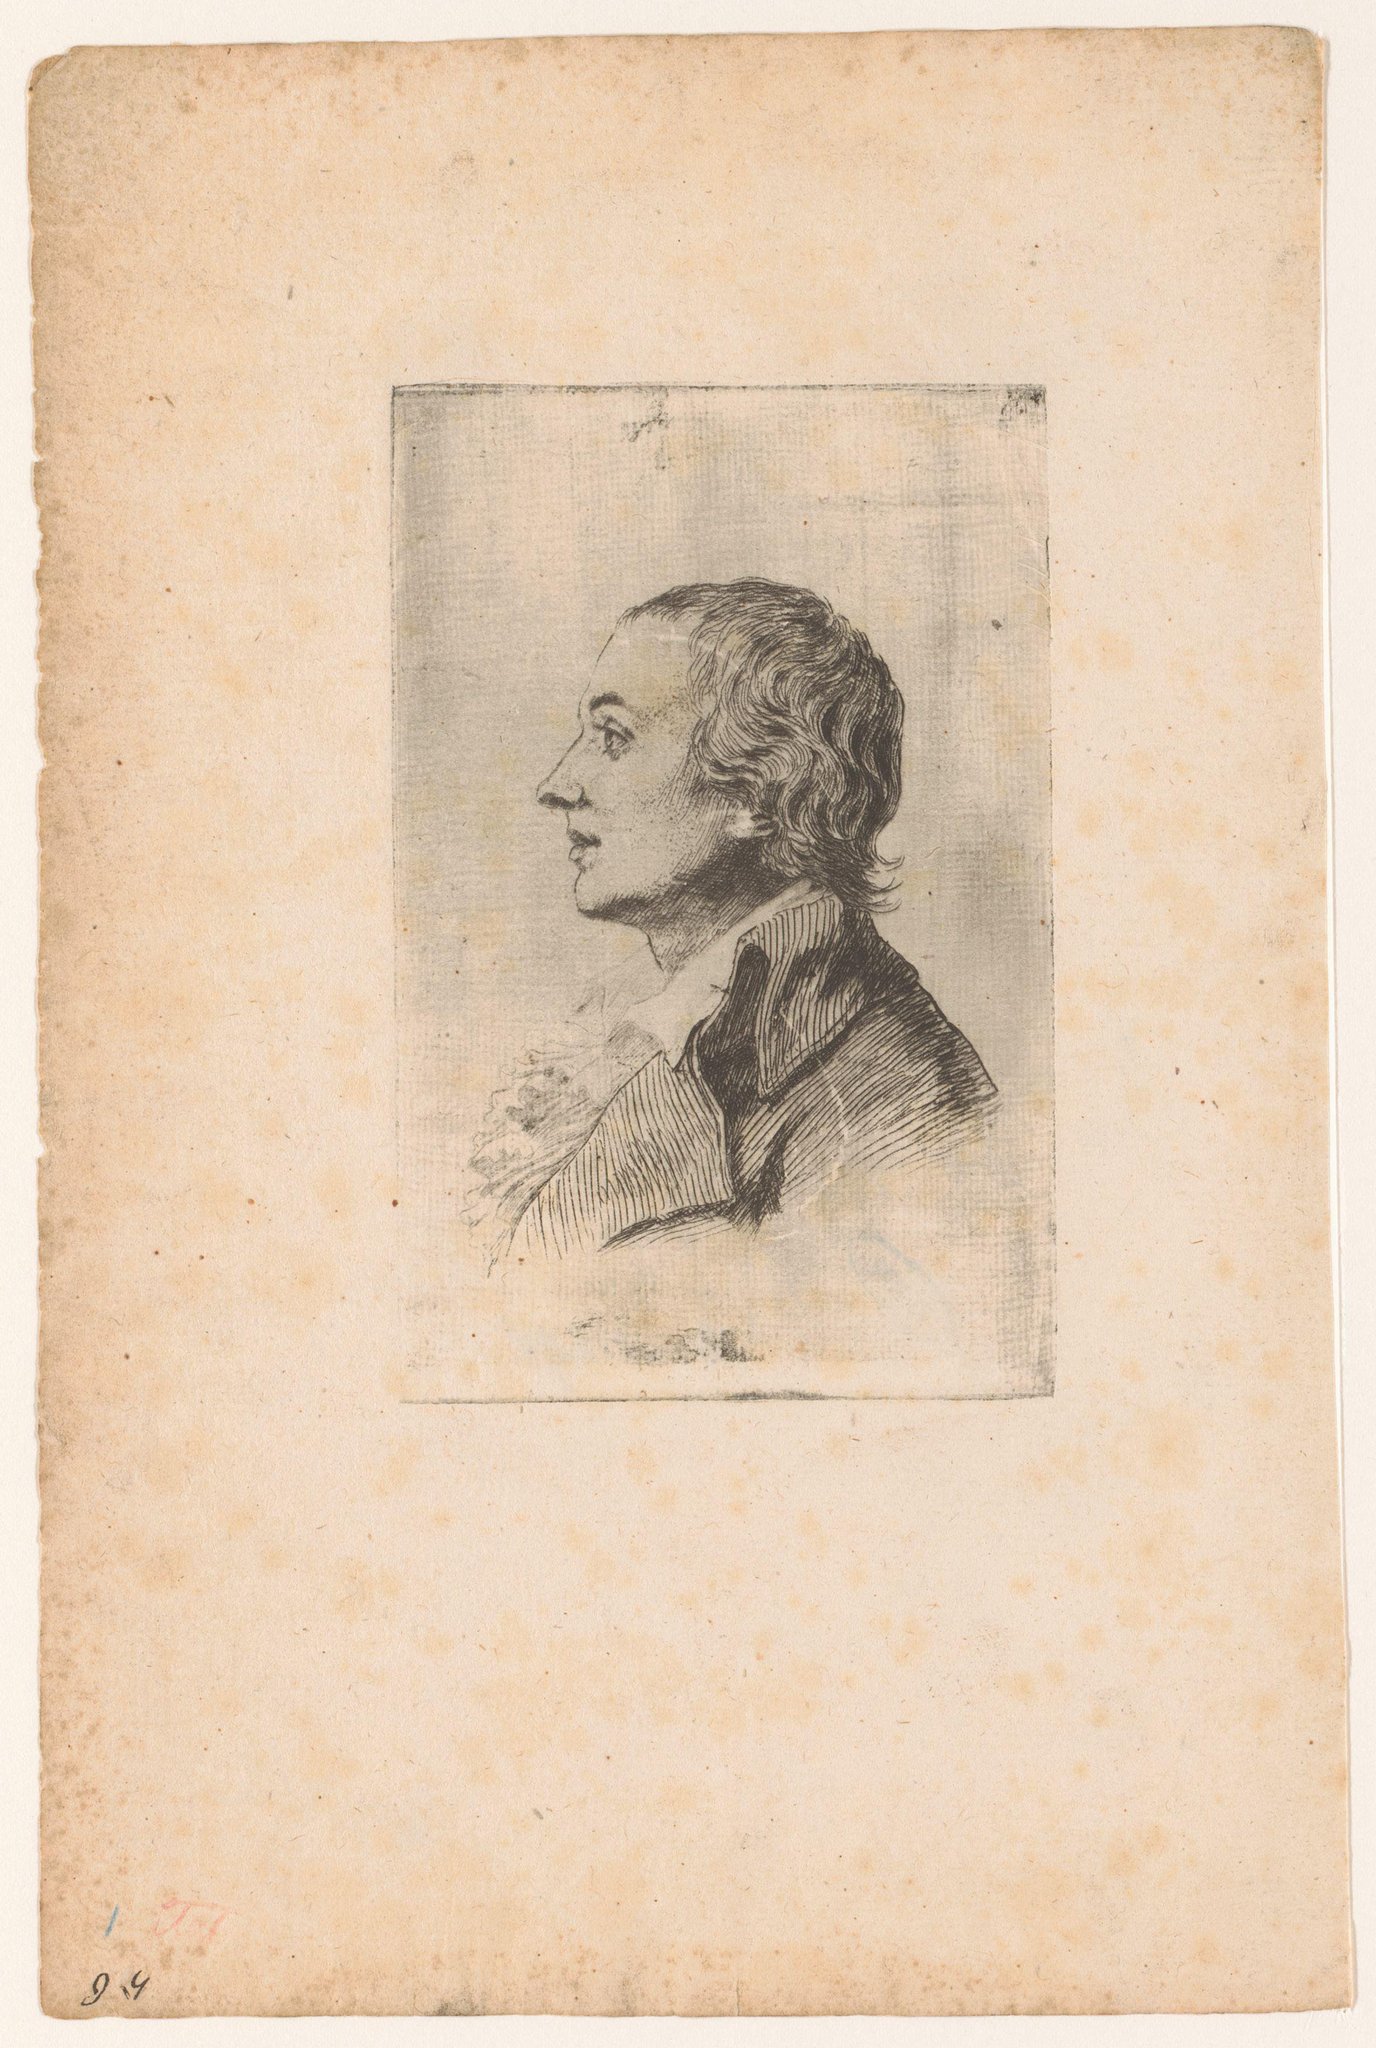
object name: print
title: Portret van een onbekende jongeman met jabot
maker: adrien de witte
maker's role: print maker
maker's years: 1850-1935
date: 1860-1913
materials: paper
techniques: etching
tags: neck-gear: jabot, historical persons, youth, adolescent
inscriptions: collector's mark: Lugt 2228